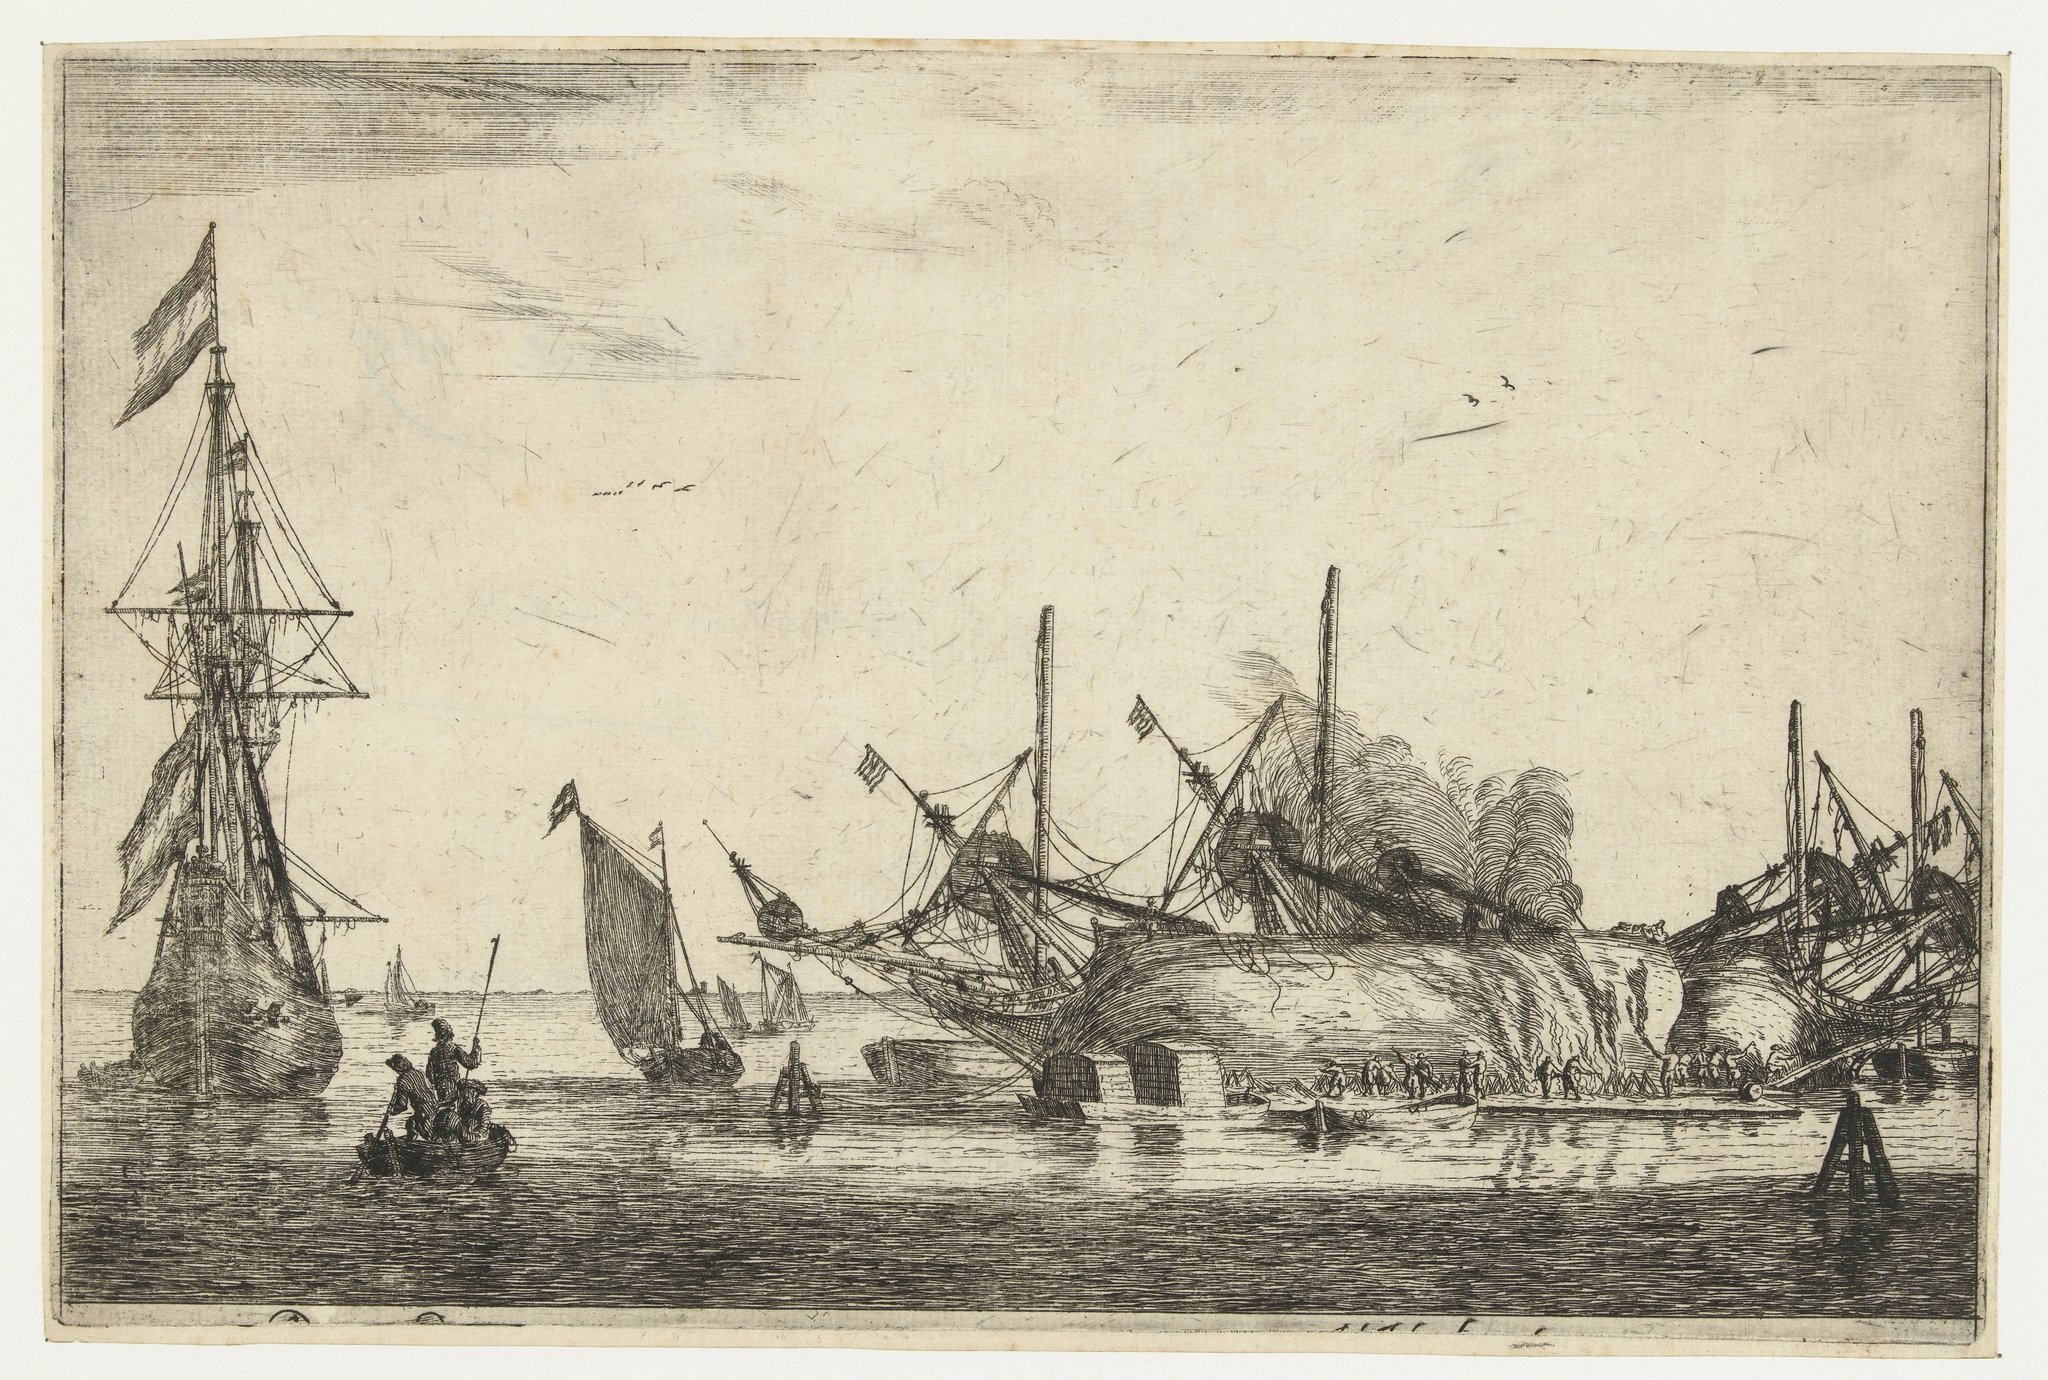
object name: print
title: Dertien scènes met schepen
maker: reinier nooms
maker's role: draughtsman, painter, print maker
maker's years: 1623-1664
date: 1650-1664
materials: paper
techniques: etching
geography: netherlands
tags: sailing-ship, sailing-boat (with name), repairing, caulking, careening (~ ship)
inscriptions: collector's mark: Lugt 2228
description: Twee grote zeilschepen door onderleggers gekield, mannen staand op een vlot rond de schepen werken aan het waterdichtmaken van de rompen. Geheel links een fluit, een koopvaardijschip.